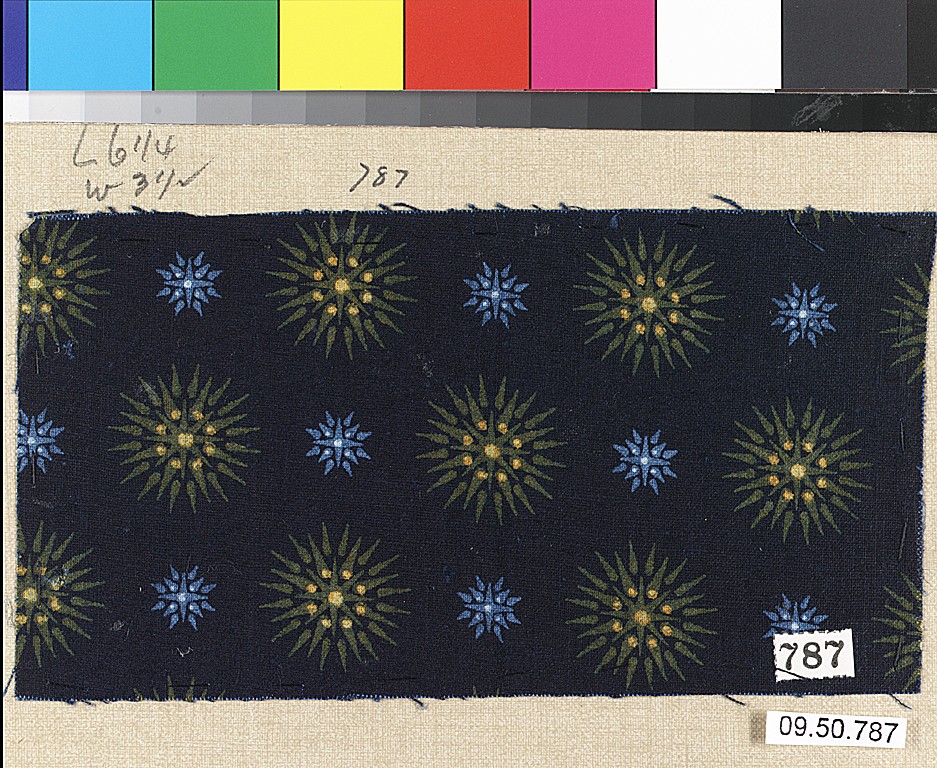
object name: piece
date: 1801-1900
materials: cotton